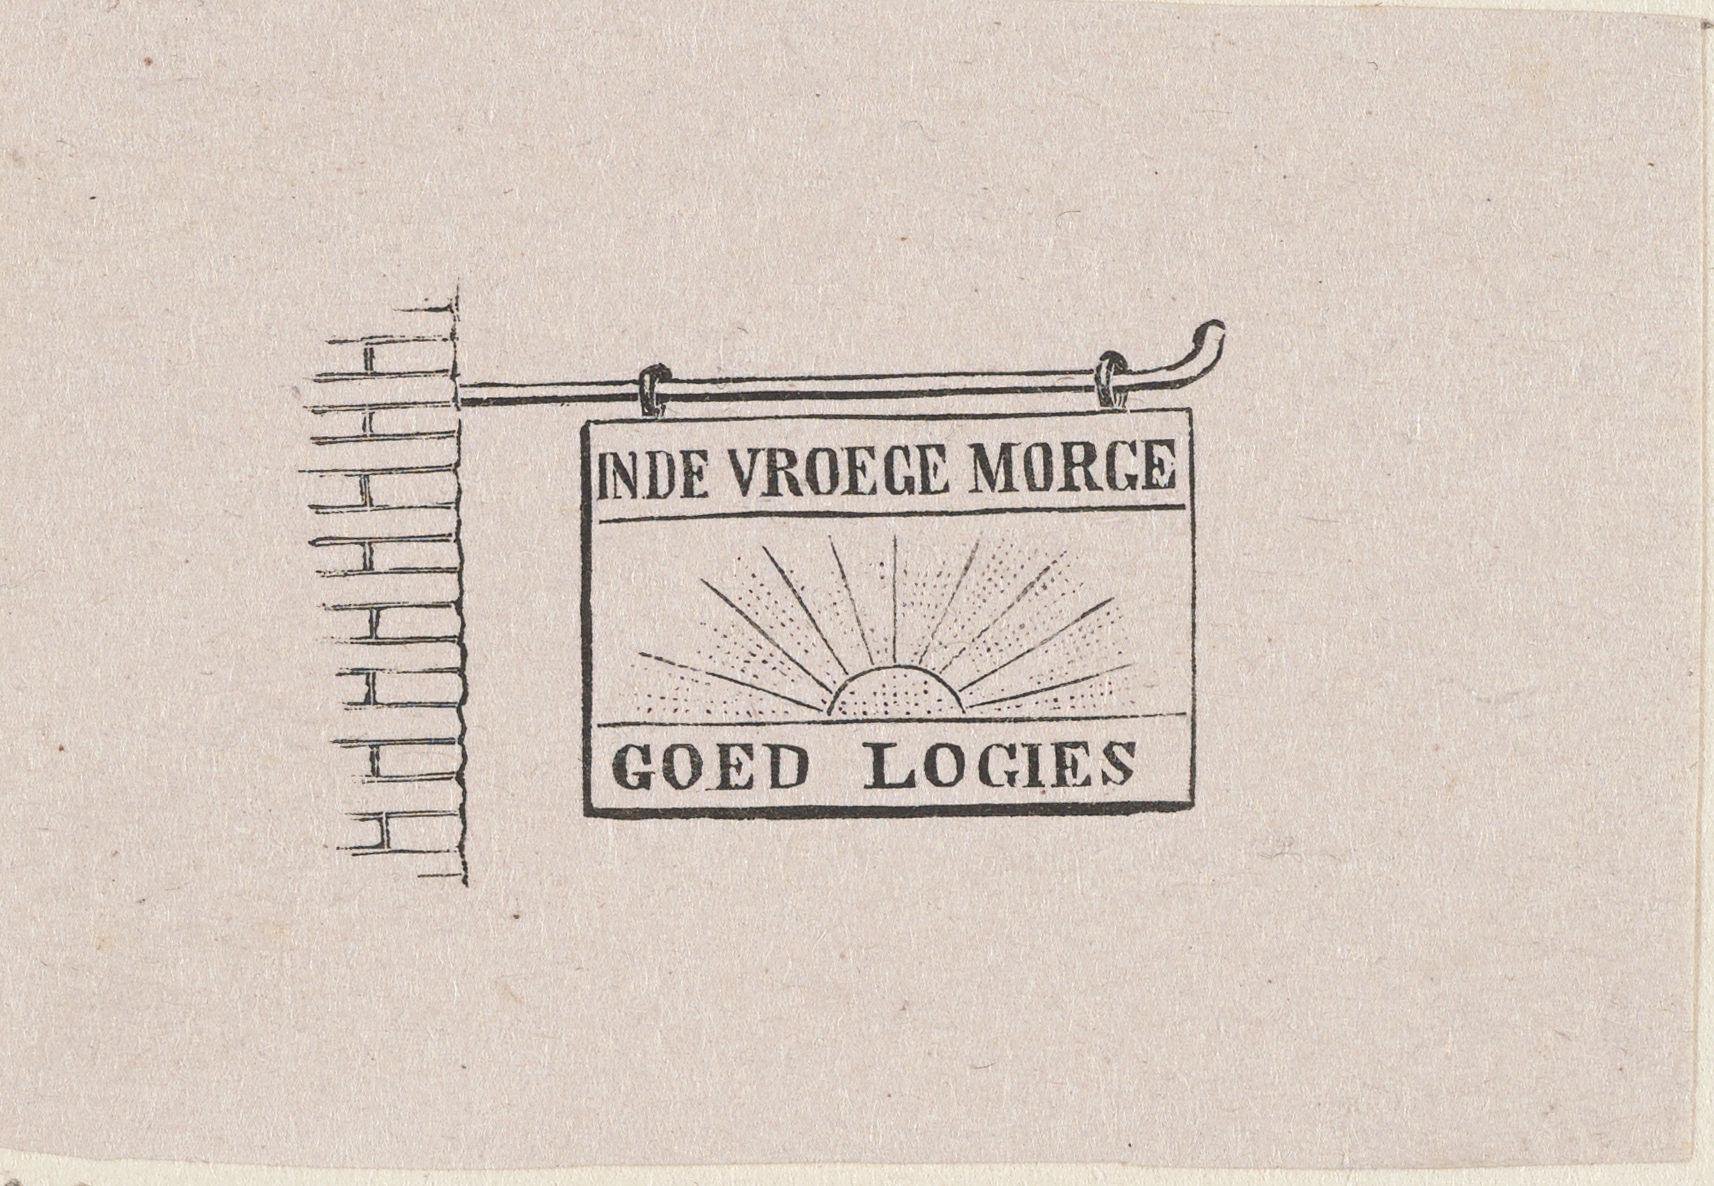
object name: print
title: Vignet met een uithangbord van een logement met daarop een zonsopgang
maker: isaac weissenbruch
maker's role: print maker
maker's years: 1826-1912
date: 1836-1912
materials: paper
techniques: engraving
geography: netherlands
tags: sunrise, signboard, vignette, hotel, hostelry, inn